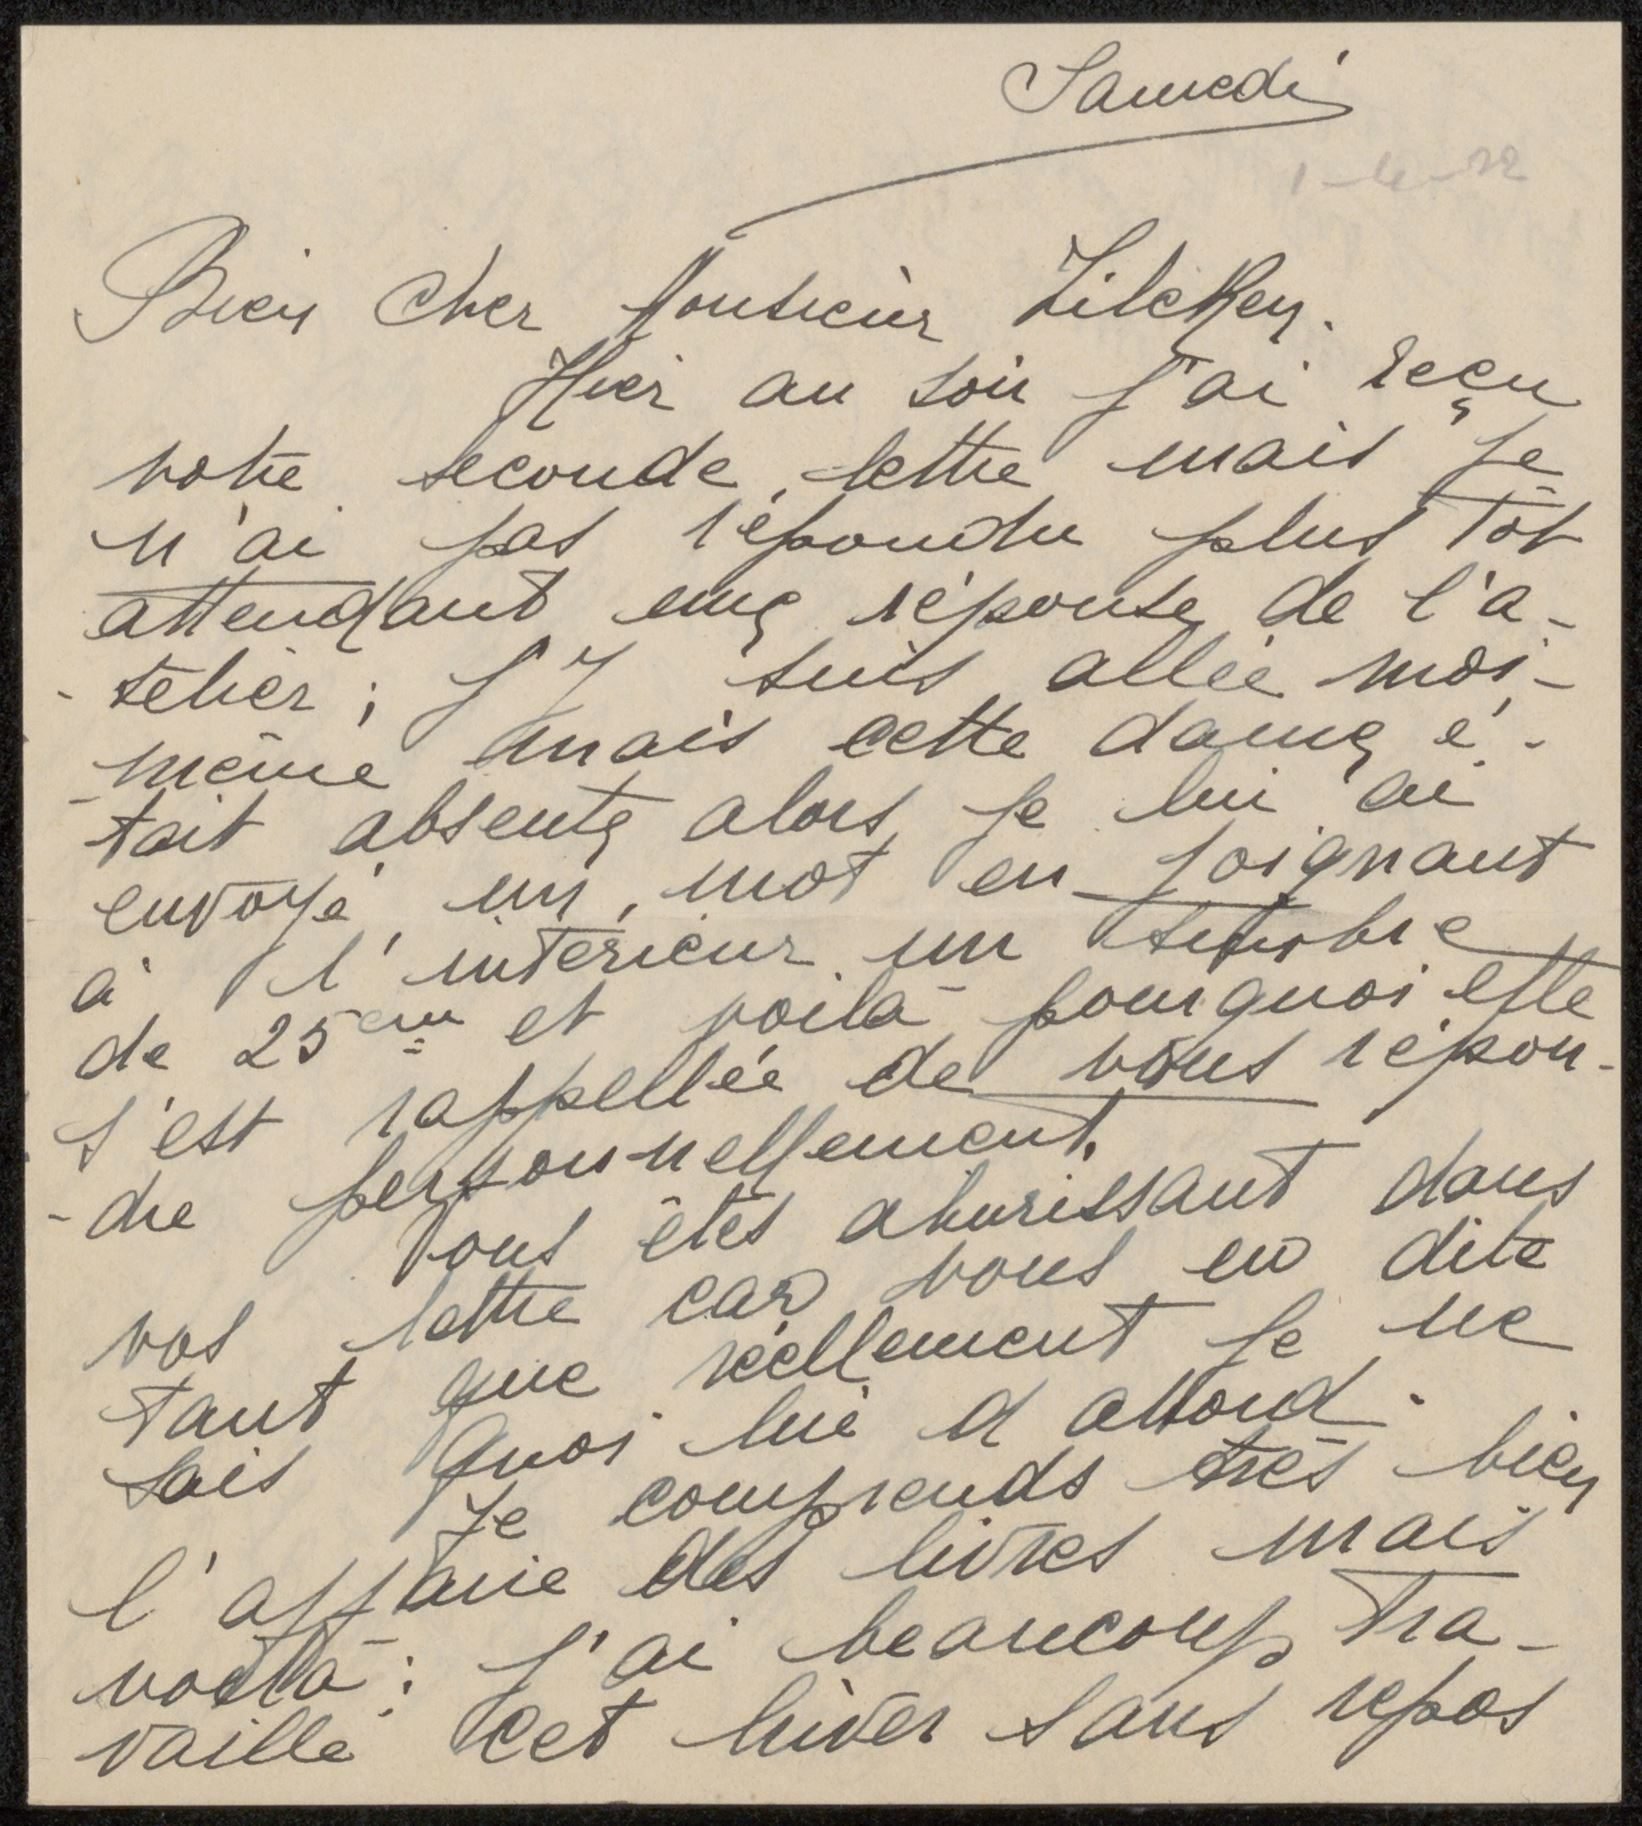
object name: letter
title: Brief aan Philip Zilcken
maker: rose imel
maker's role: draughtsman, painter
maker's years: 1901-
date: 1911-1930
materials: ink, paper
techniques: pen, writing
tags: the hague, painter, draughtsman, philip zilcken, workshop, studio of the artist (in general), antwerp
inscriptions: collector's mark: ‘RPK’